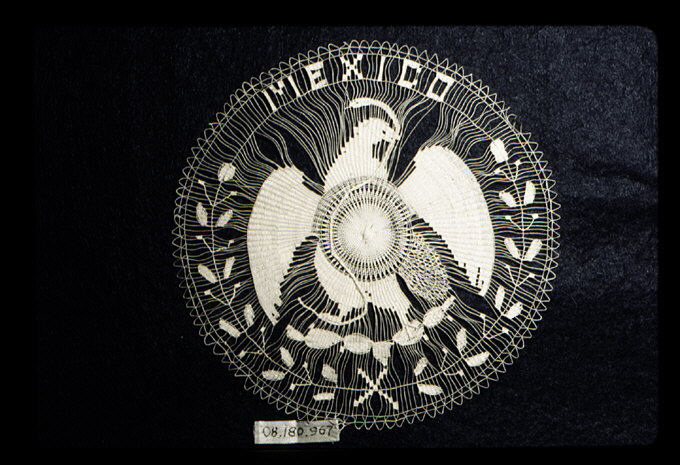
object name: medallion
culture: mexican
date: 1801-1900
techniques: embroidery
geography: mexico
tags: eagles